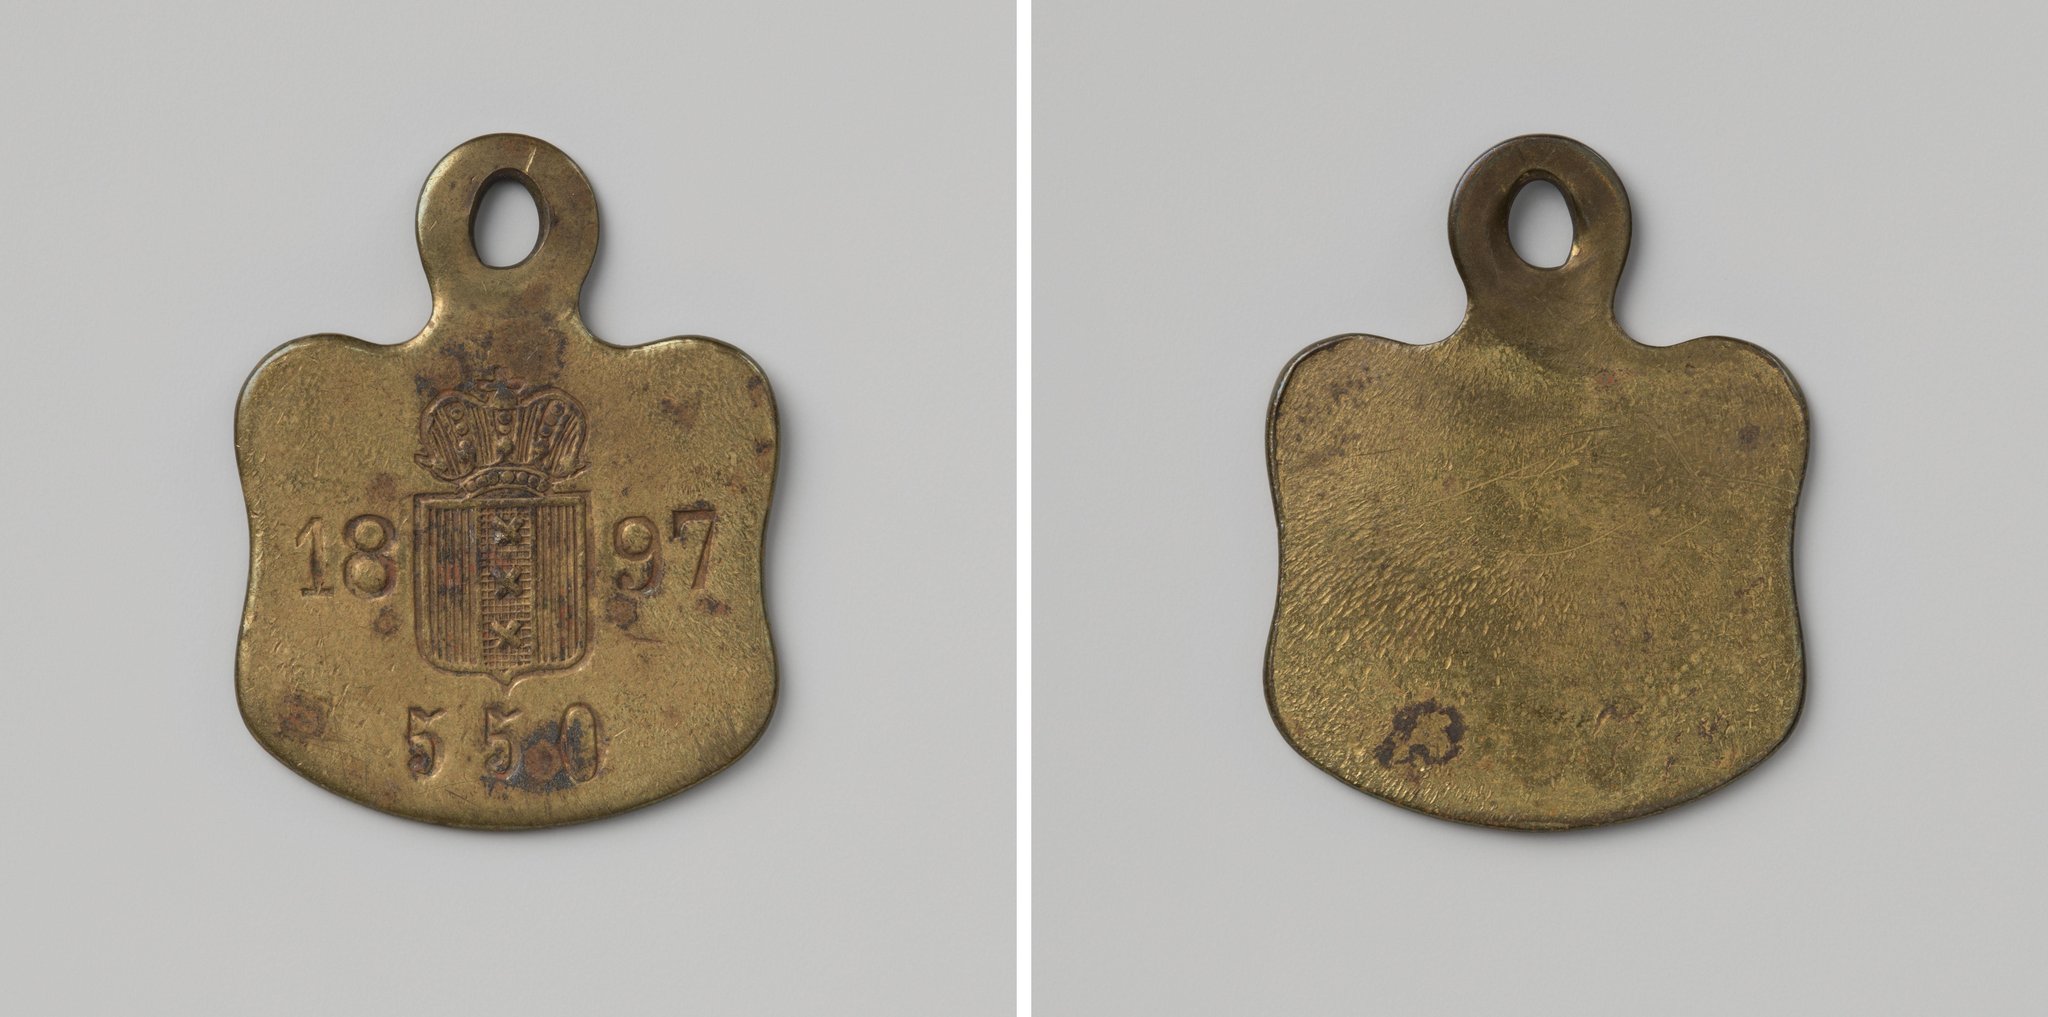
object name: hondenbelastingloodje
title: Stad Amsterdam, loodje met no. 550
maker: Anonymous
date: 1897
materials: brass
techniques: striking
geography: amsterdam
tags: amsterdam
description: eenzijdig loodje aan draagoog met afgeronde hoeken, holle zijden en bolle onderzijde. Voorzijde: gekroond wapenschild tussen jaartal boven cijfer 550. Keerzijde: blanco